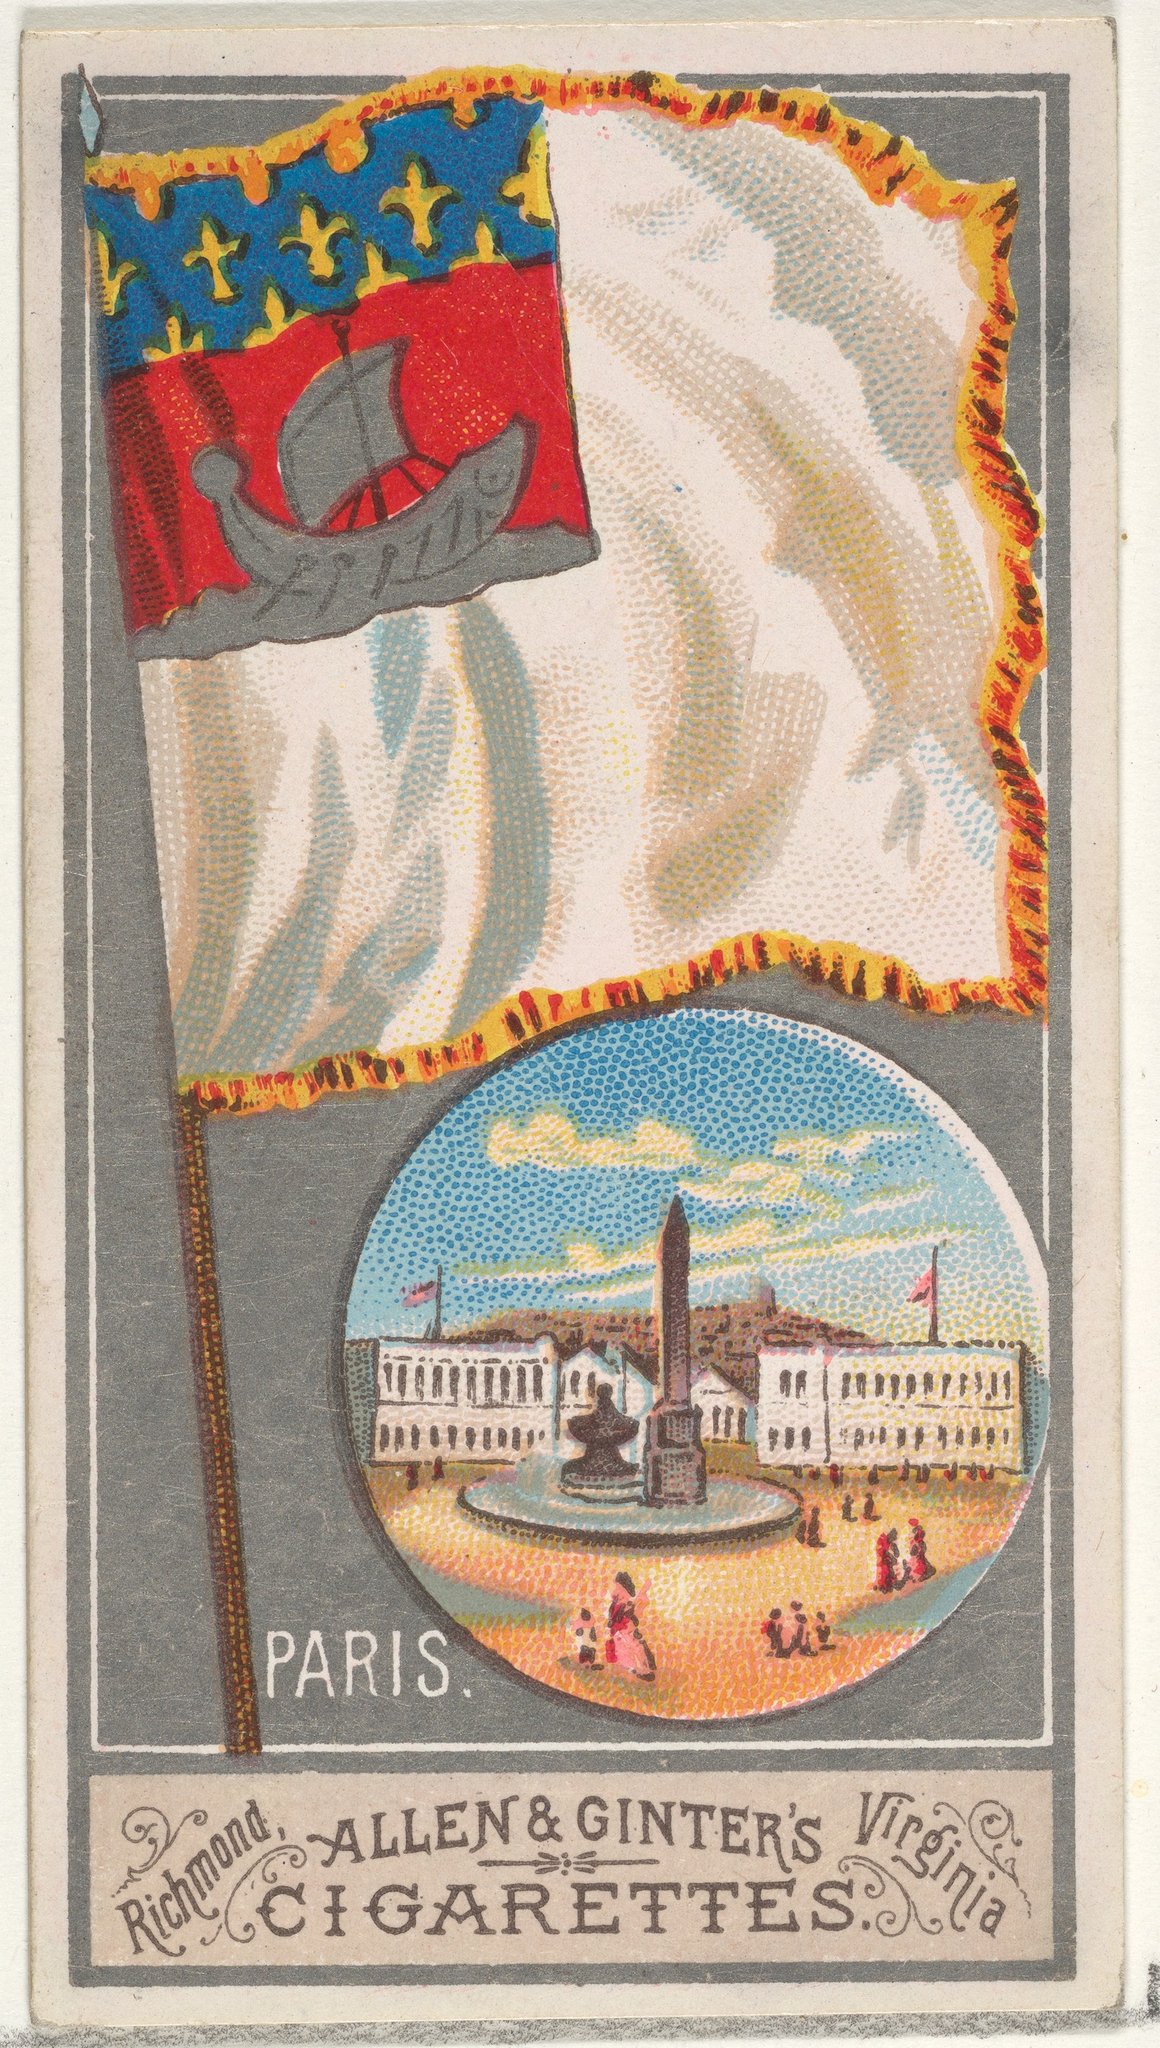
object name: print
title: Paris, from the City Flags series (N6) for Allen & Ginter Cigarettes Brands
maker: allen & ginter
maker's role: publisher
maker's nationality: american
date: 1887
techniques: color lithograph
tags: flags